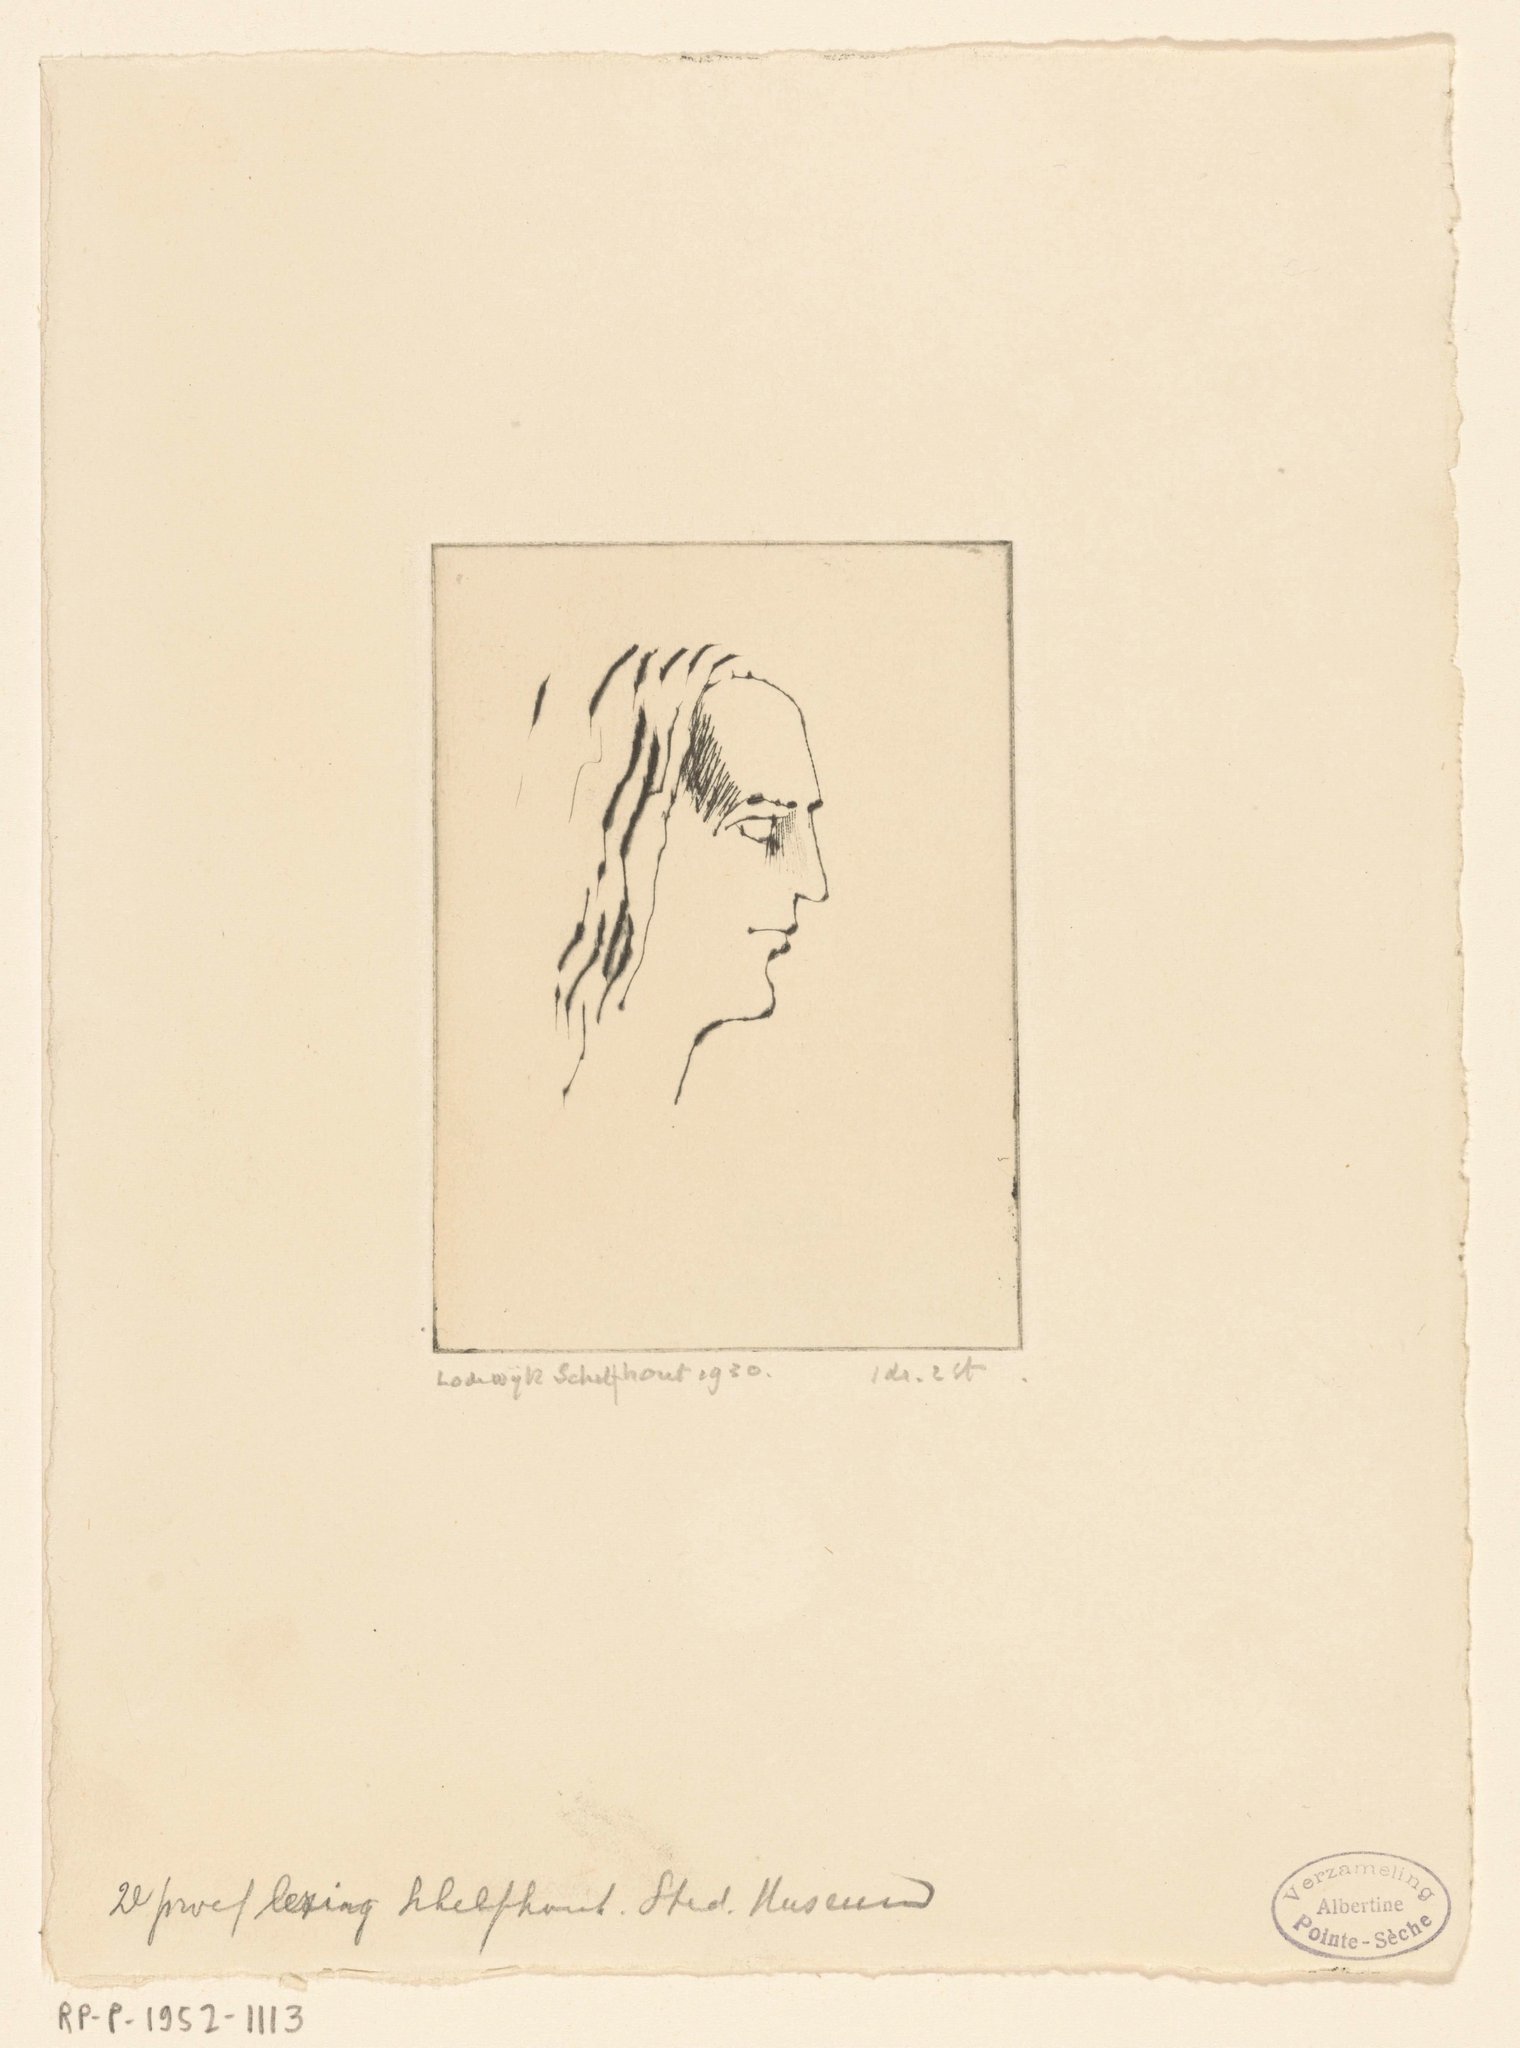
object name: print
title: Petite tête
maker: lodewijk schelfhout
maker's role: draughtsman, print maker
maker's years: 1881-1943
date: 1930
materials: paper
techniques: drypoint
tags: eyes closed, 'portraits' of christ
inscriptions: collector's mark: Lugt 2228, collector's mark: Lugt 5i, inscription: ‘2e proef lezing Schelfhout Sted. Museum’